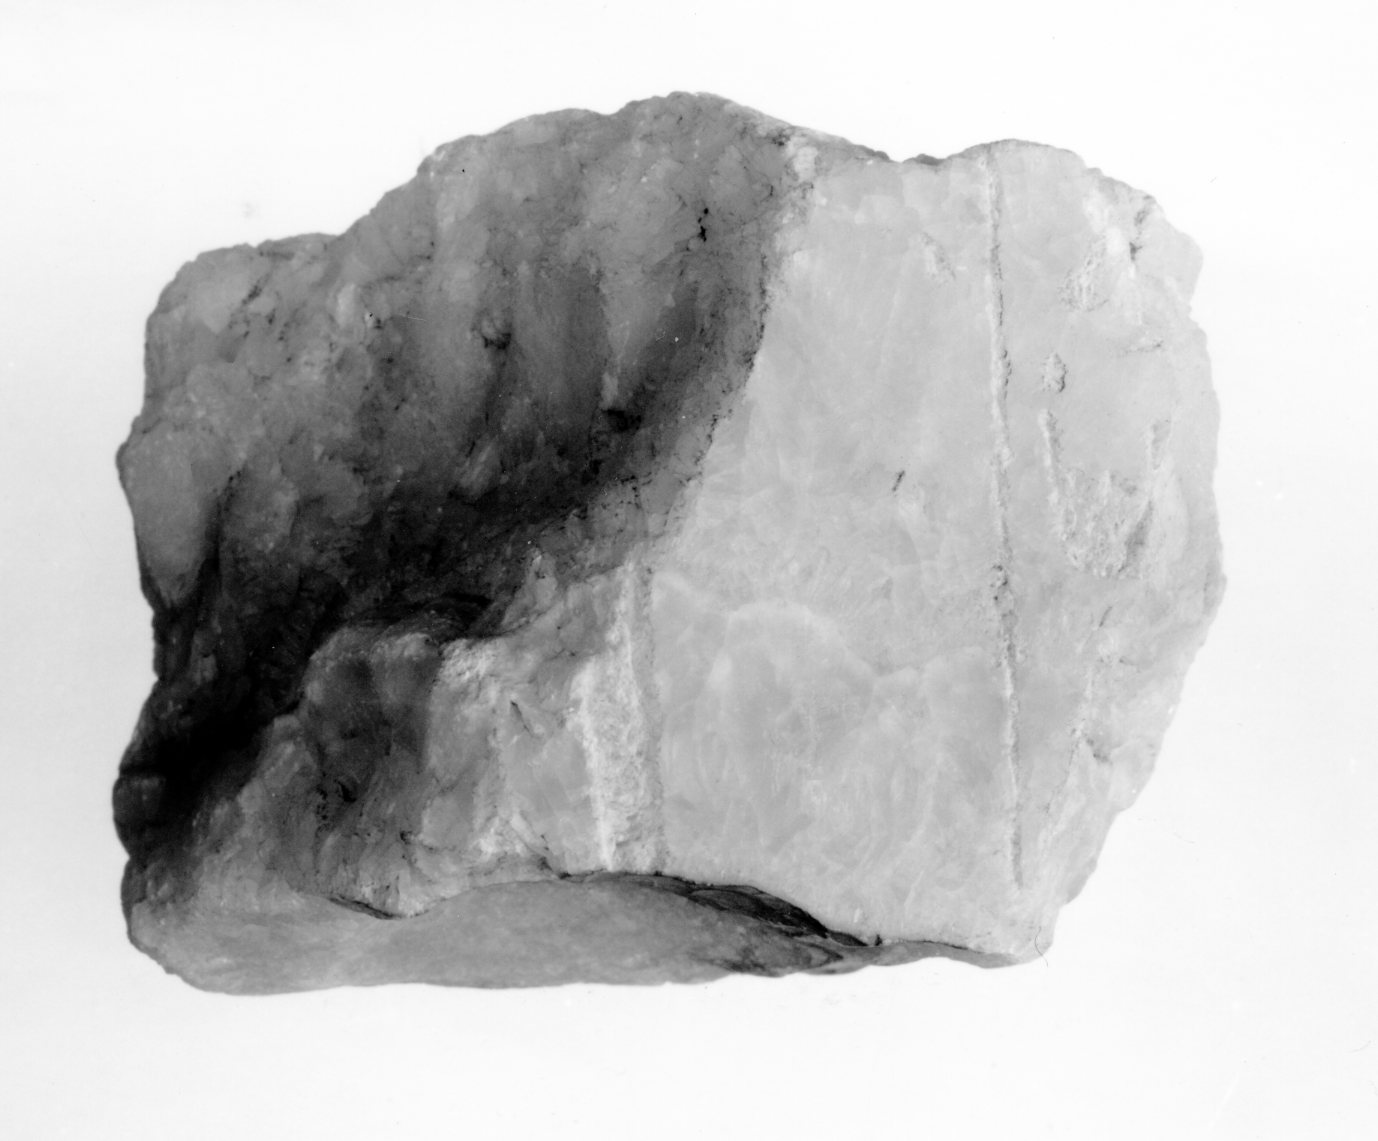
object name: canopic chest, tiye, thutmose iv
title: Fragment of a Canopic Chest of Queen Tiya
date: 1427-1390 BCE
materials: stone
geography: egypt